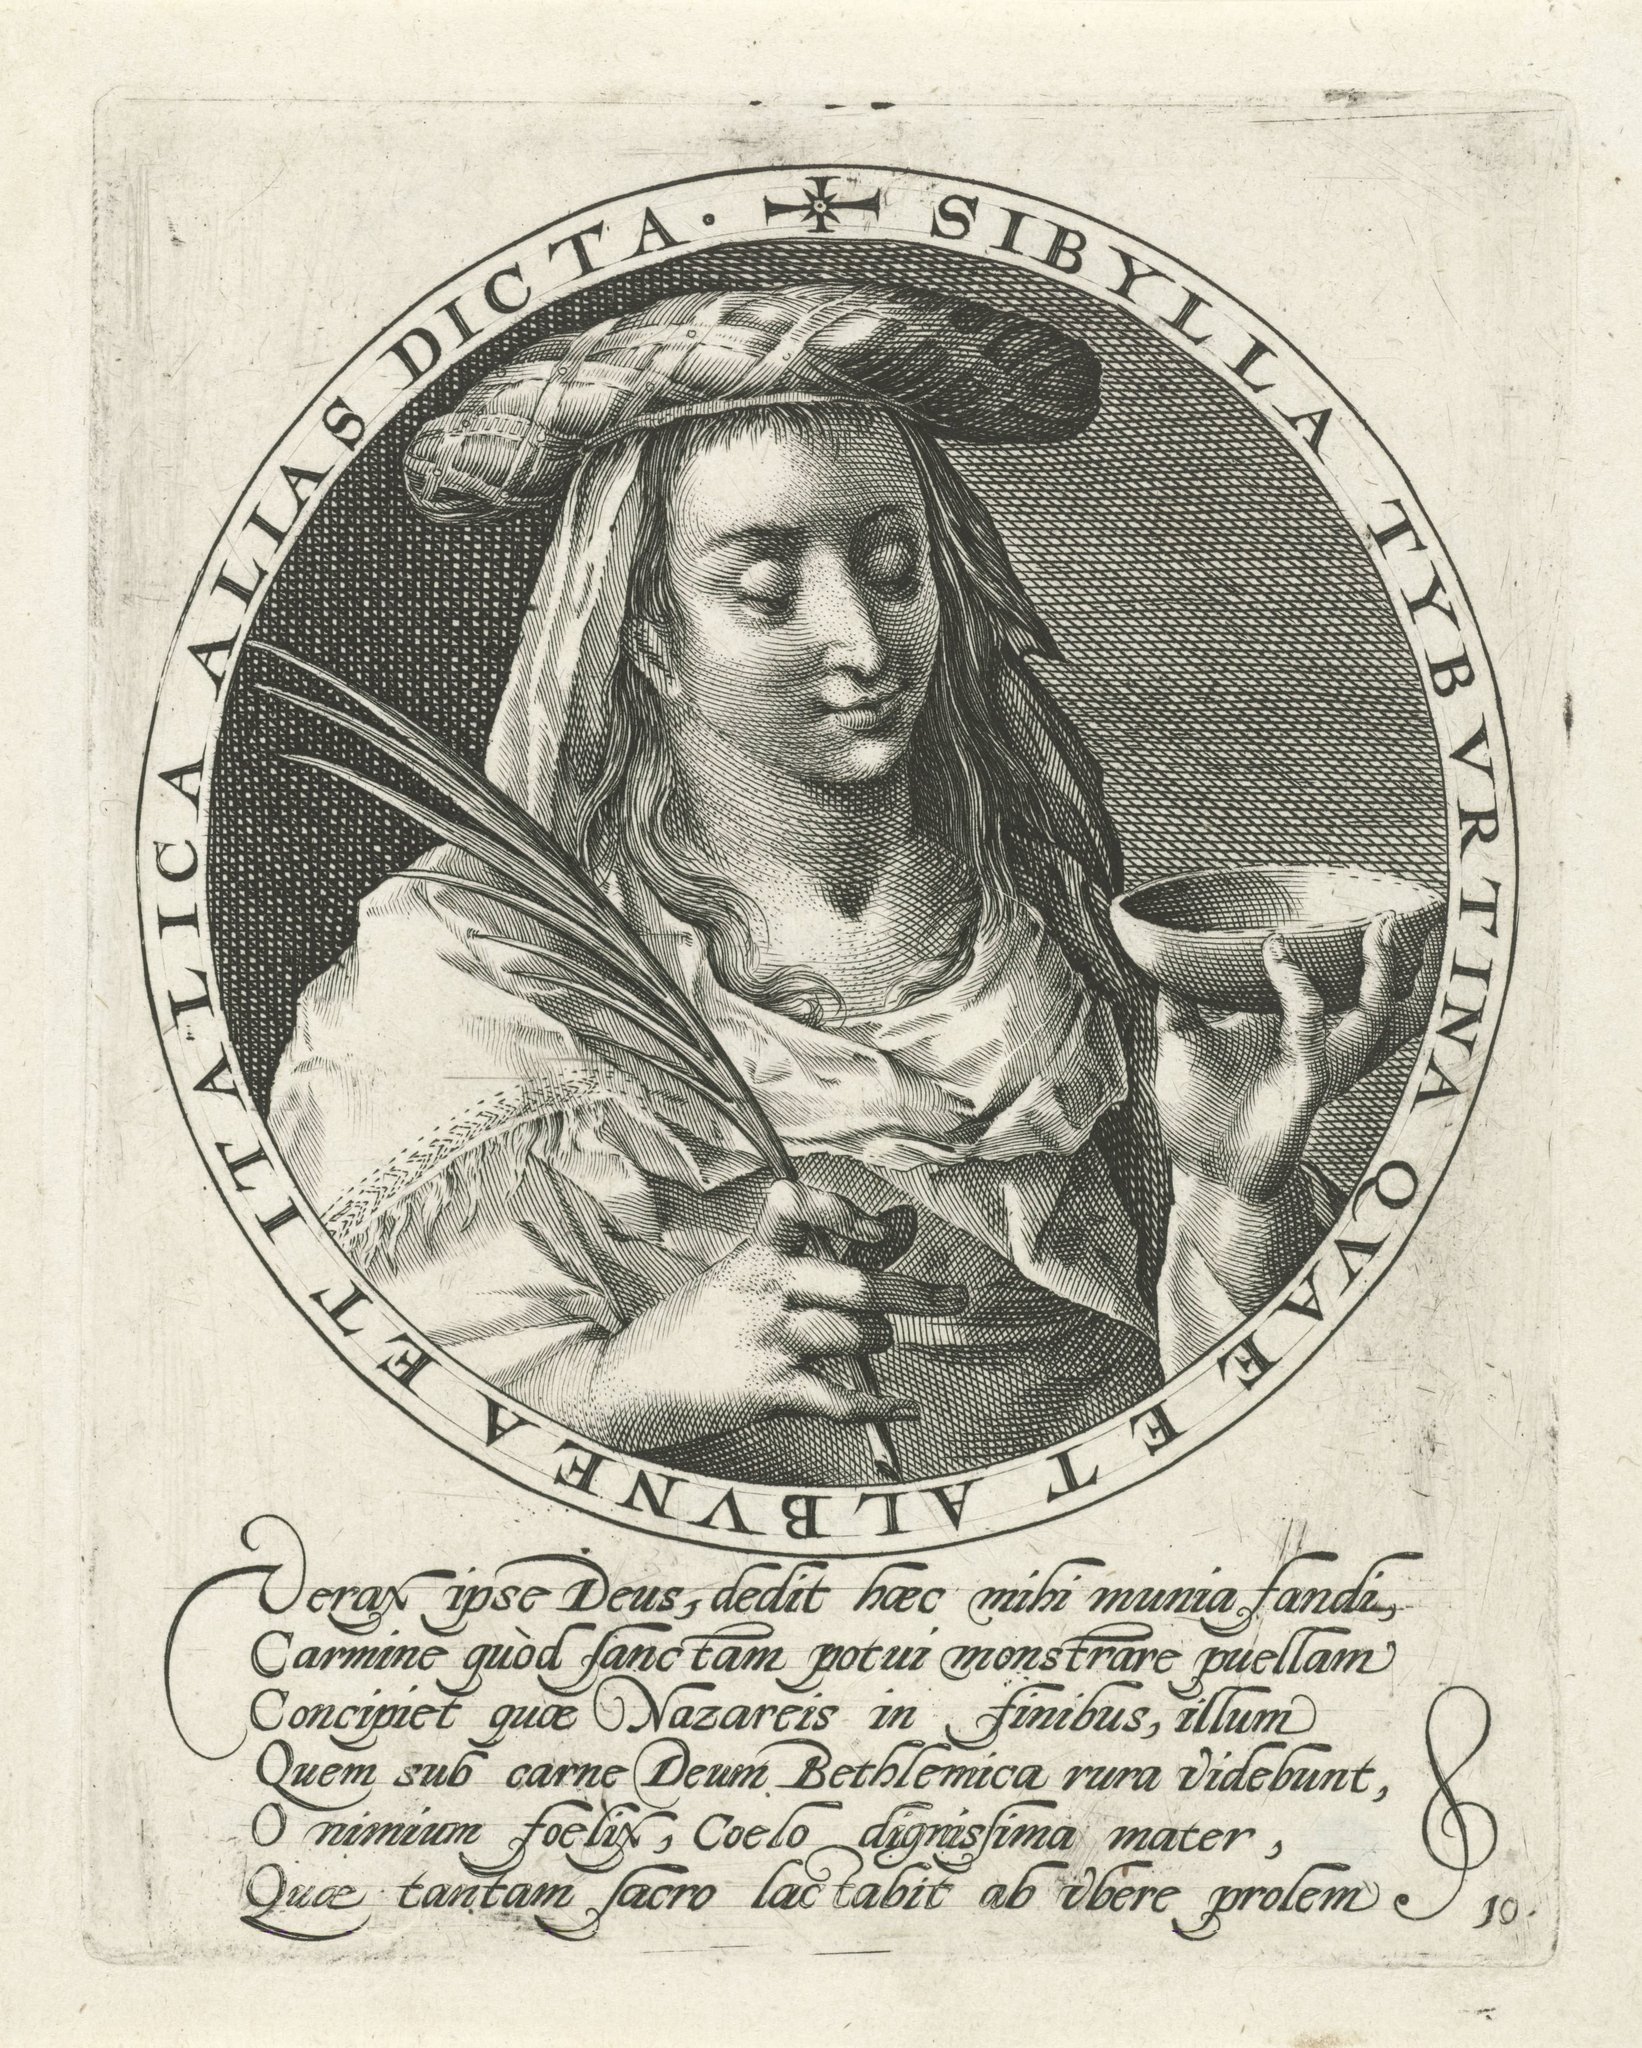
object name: print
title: XII. Sibyllarum Icones Elegantissimi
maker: crispijn van de passe (i)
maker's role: draughtsman, print maker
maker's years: 1564-1637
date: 1601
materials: paper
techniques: engraving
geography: cologne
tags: sibyls (with name)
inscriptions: collector's mark: Lugt 2228, collector's mark: Lugt 1337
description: Buste van de Tiburtijnse Sibille. In haar linkerhand houdt ze een schaal en in haar rechterhand een palmtak. De voorstelling is gevat in een medaillon met een randschrift in het Latijn. In de marge een zesregelig onderschrift in het Latijn. Prent uit een serie met de twaalf sibillen.